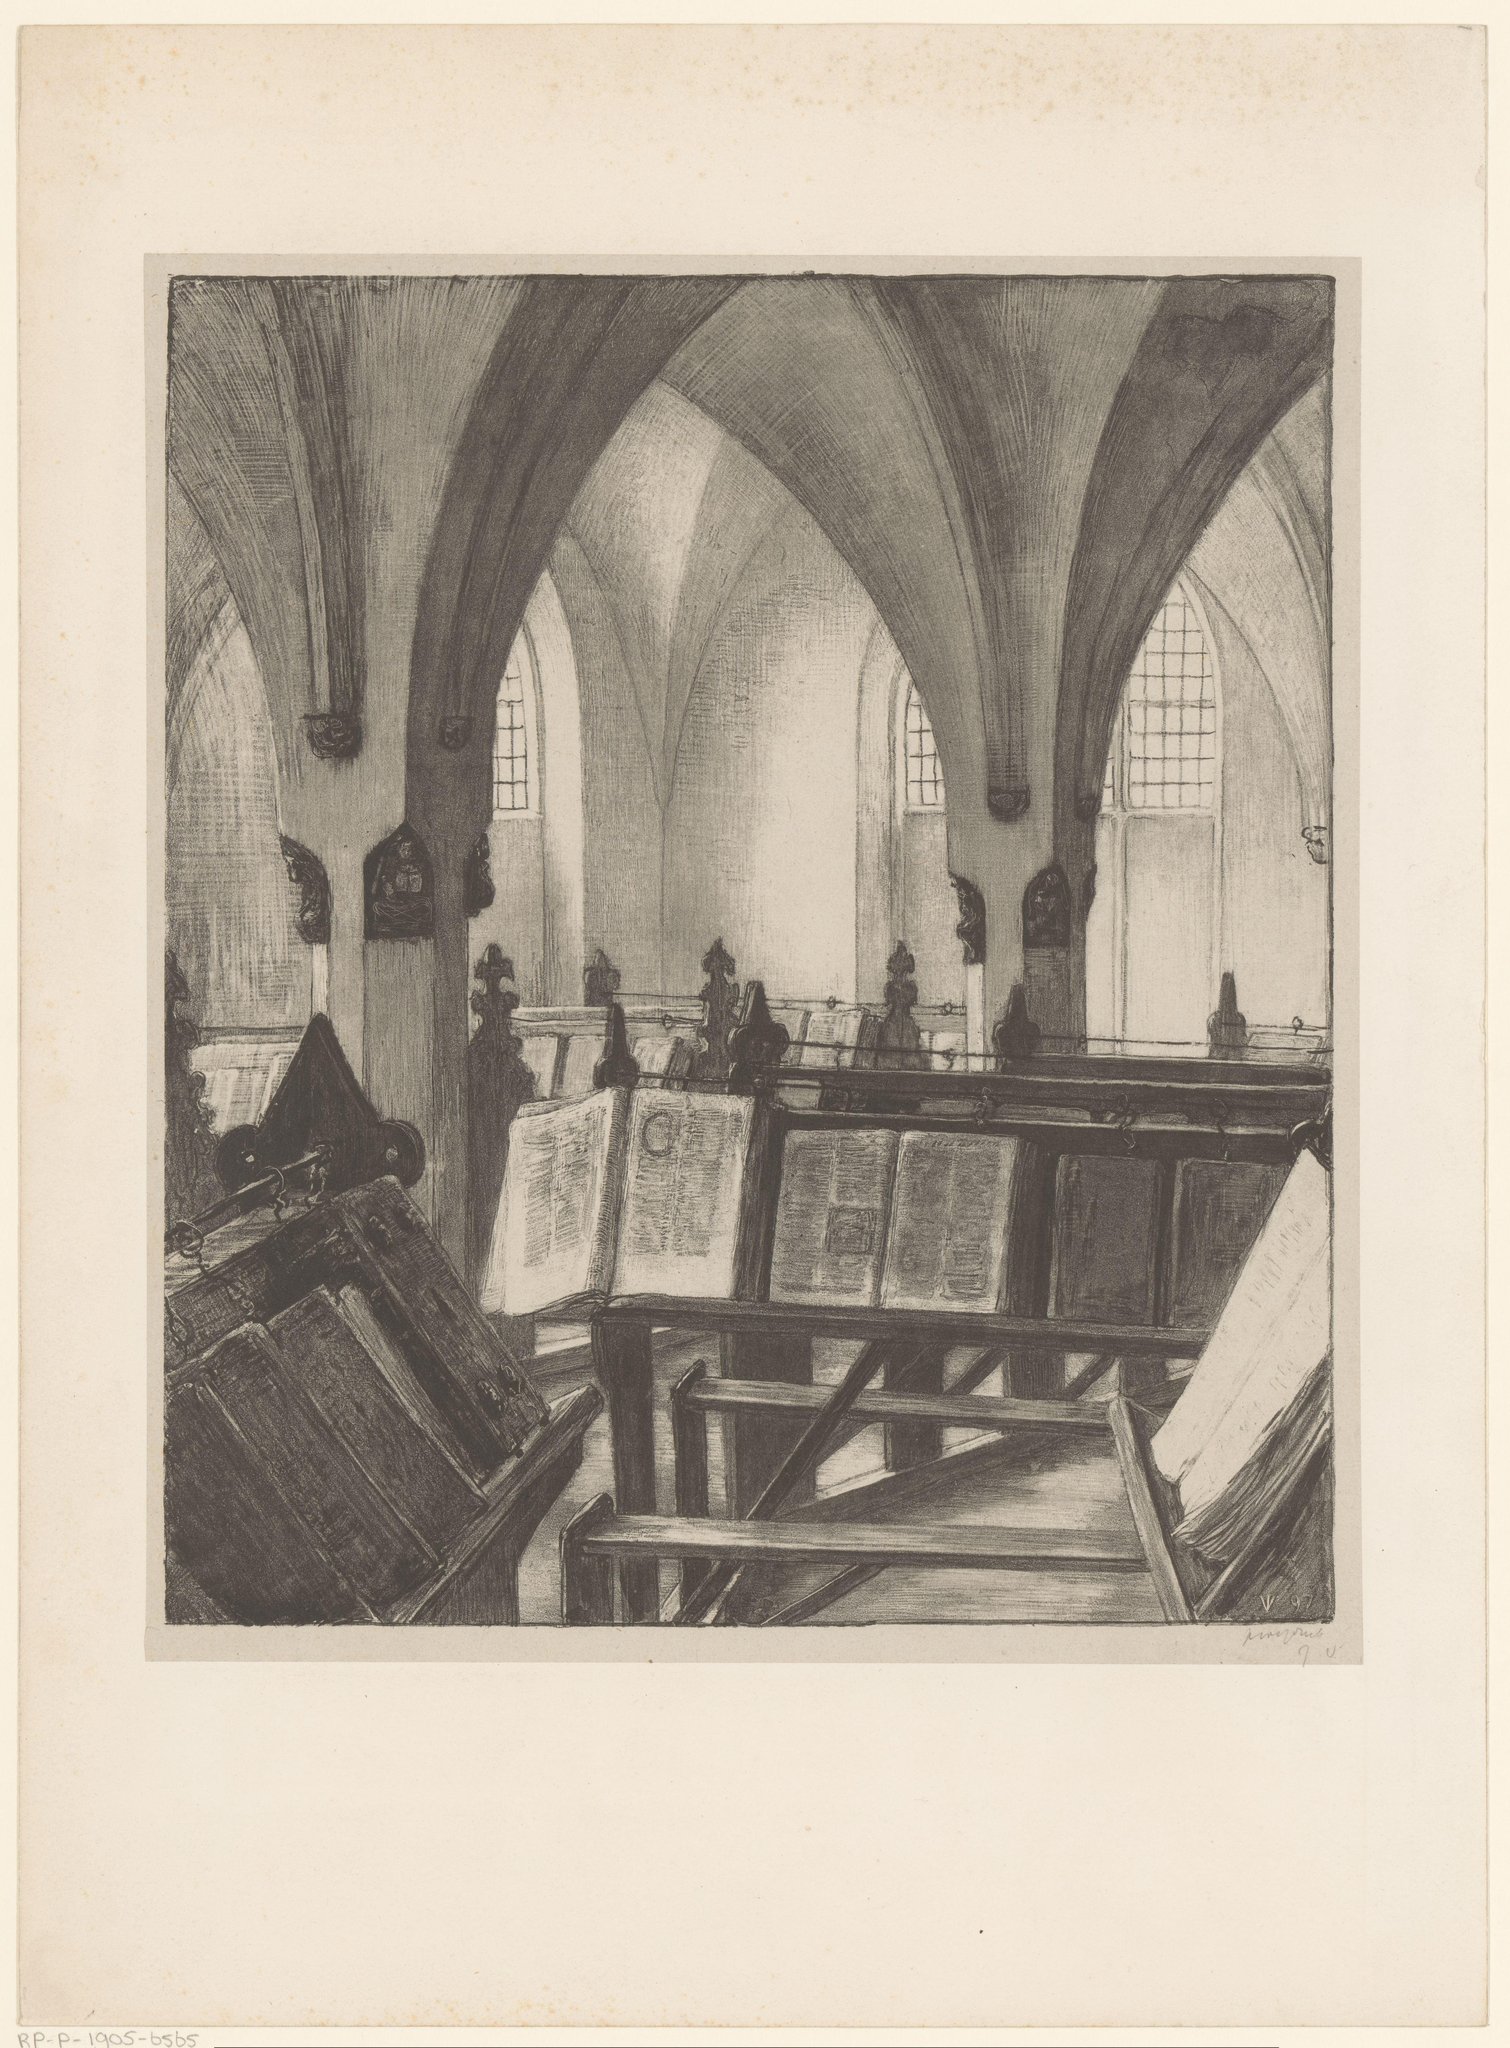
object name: print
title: Librije te Zutphen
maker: jan veth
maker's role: designer, draughtsman, painter, print maker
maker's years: 1864-1925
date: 1897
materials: paper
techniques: lithograph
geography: netherlands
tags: public library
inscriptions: inscription: ‘proefdruk / J.V.’, collector's mark: Lugt 2228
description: Deze prent werd uitgegeven als bijvoegsel bij De Kroniek op 26 september 1897.